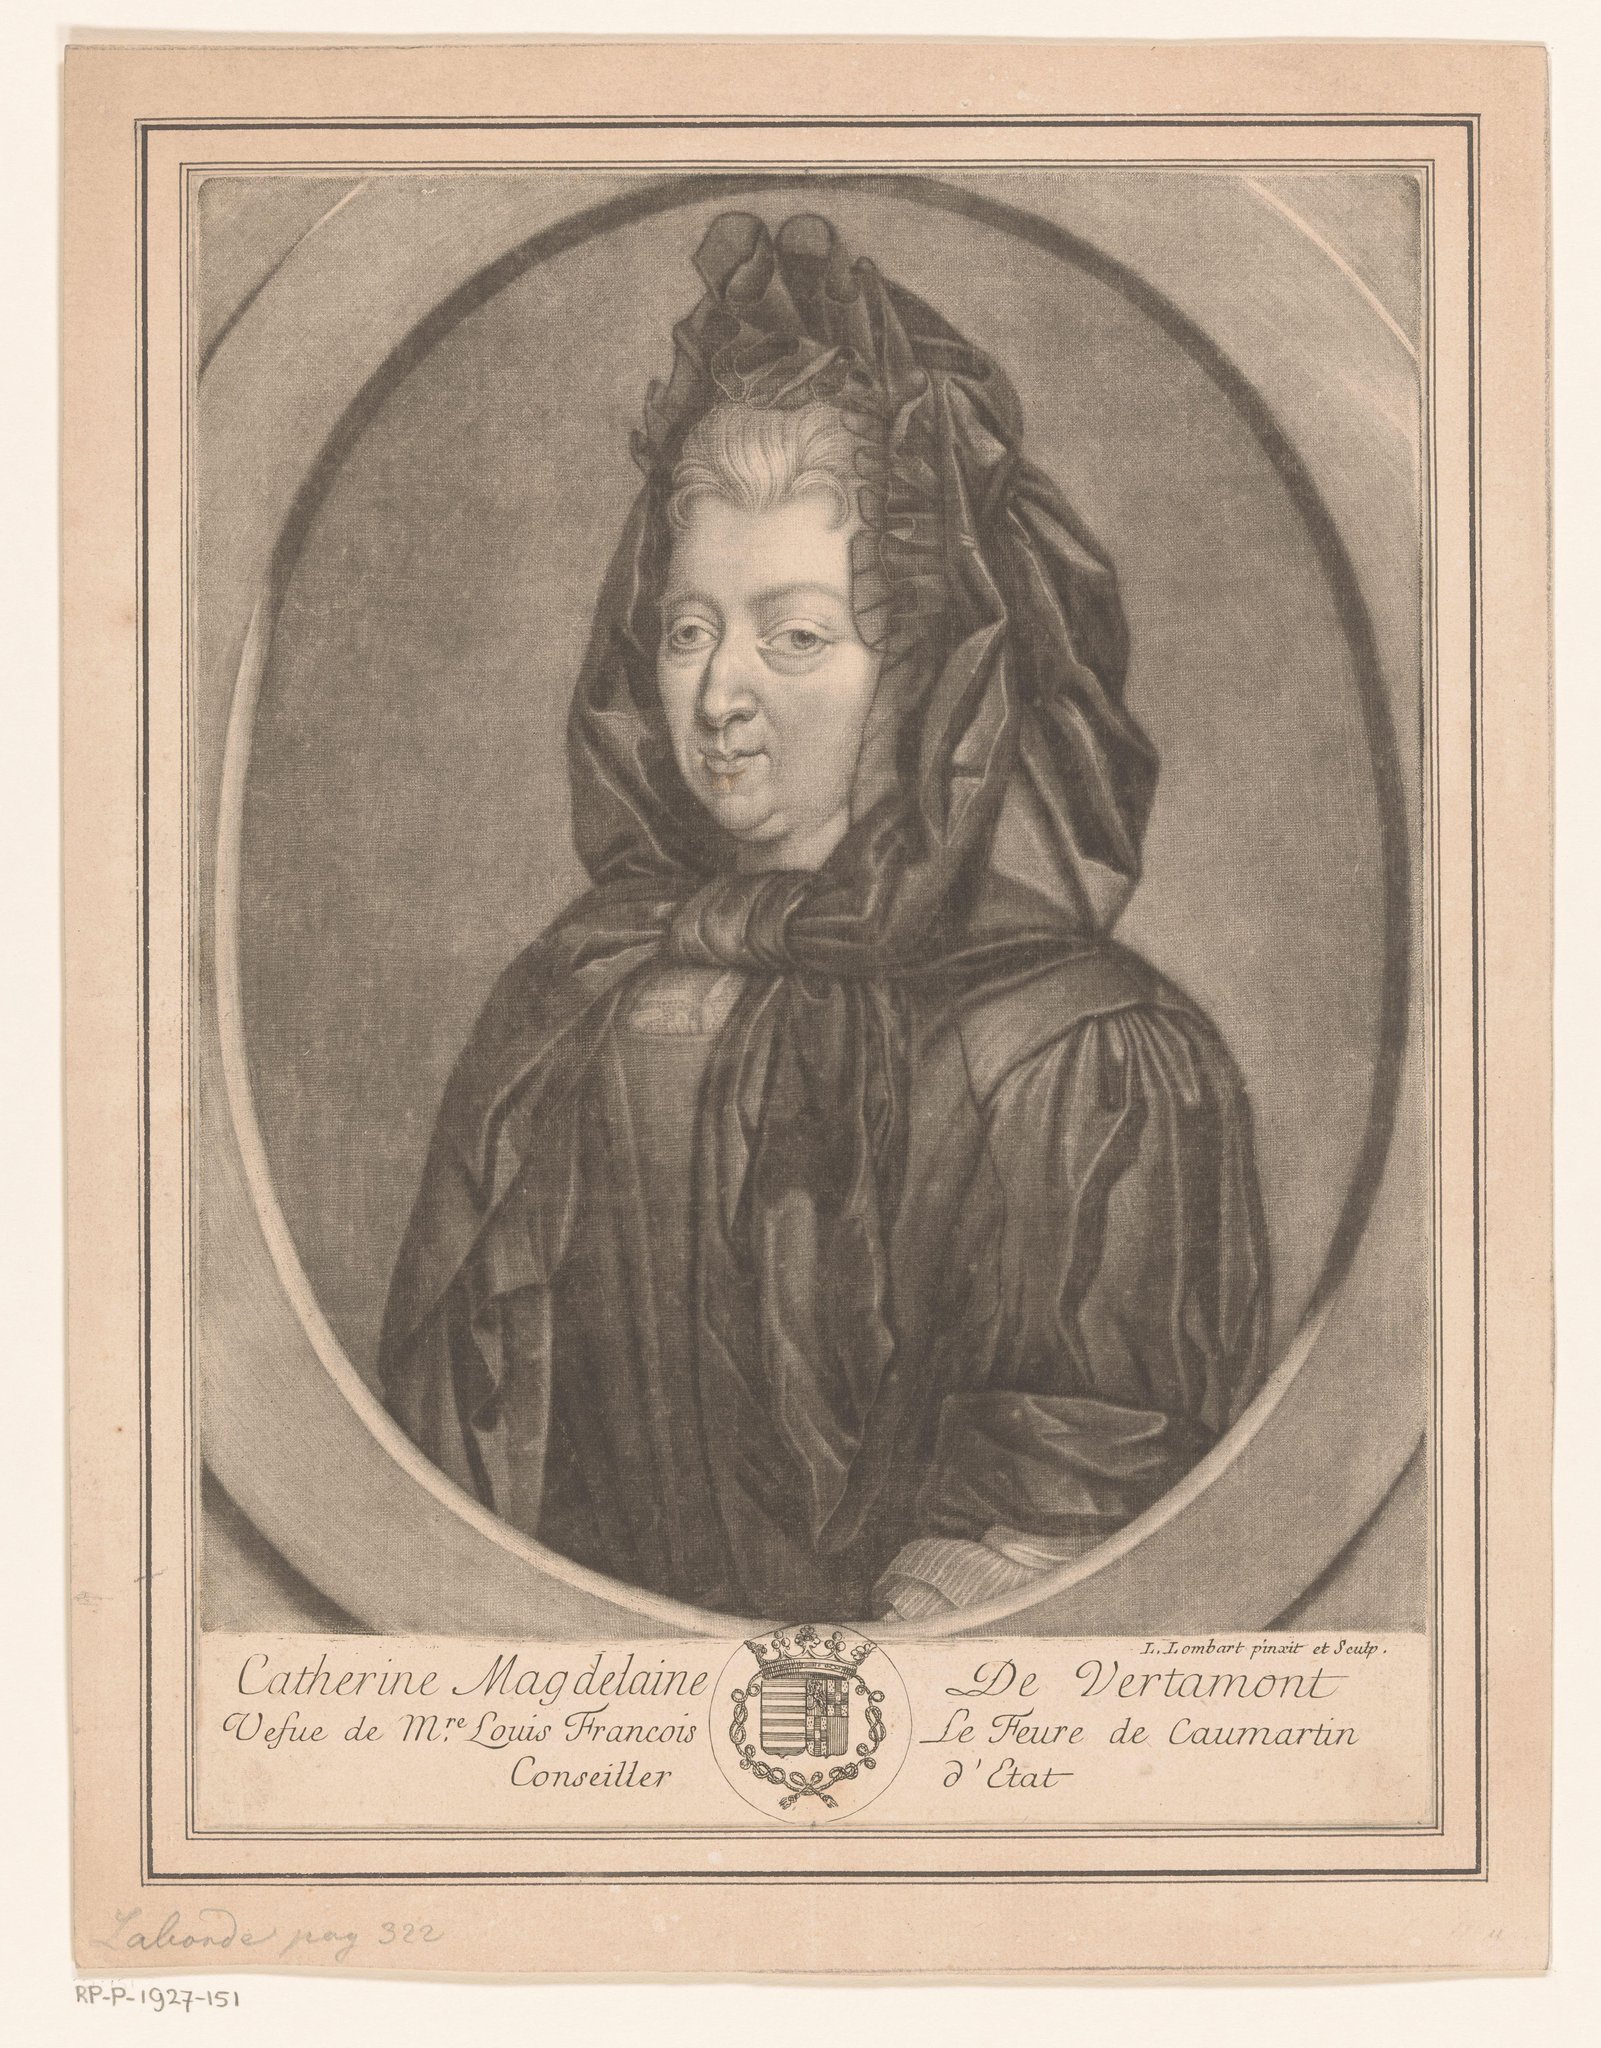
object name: print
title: Portret van Catherine Madeleine de Vertamont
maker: louis lombard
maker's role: print maker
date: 1687-1722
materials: paper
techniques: mezzotint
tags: historical persons - bb - woman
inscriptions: collector's mark: Lugt 2166